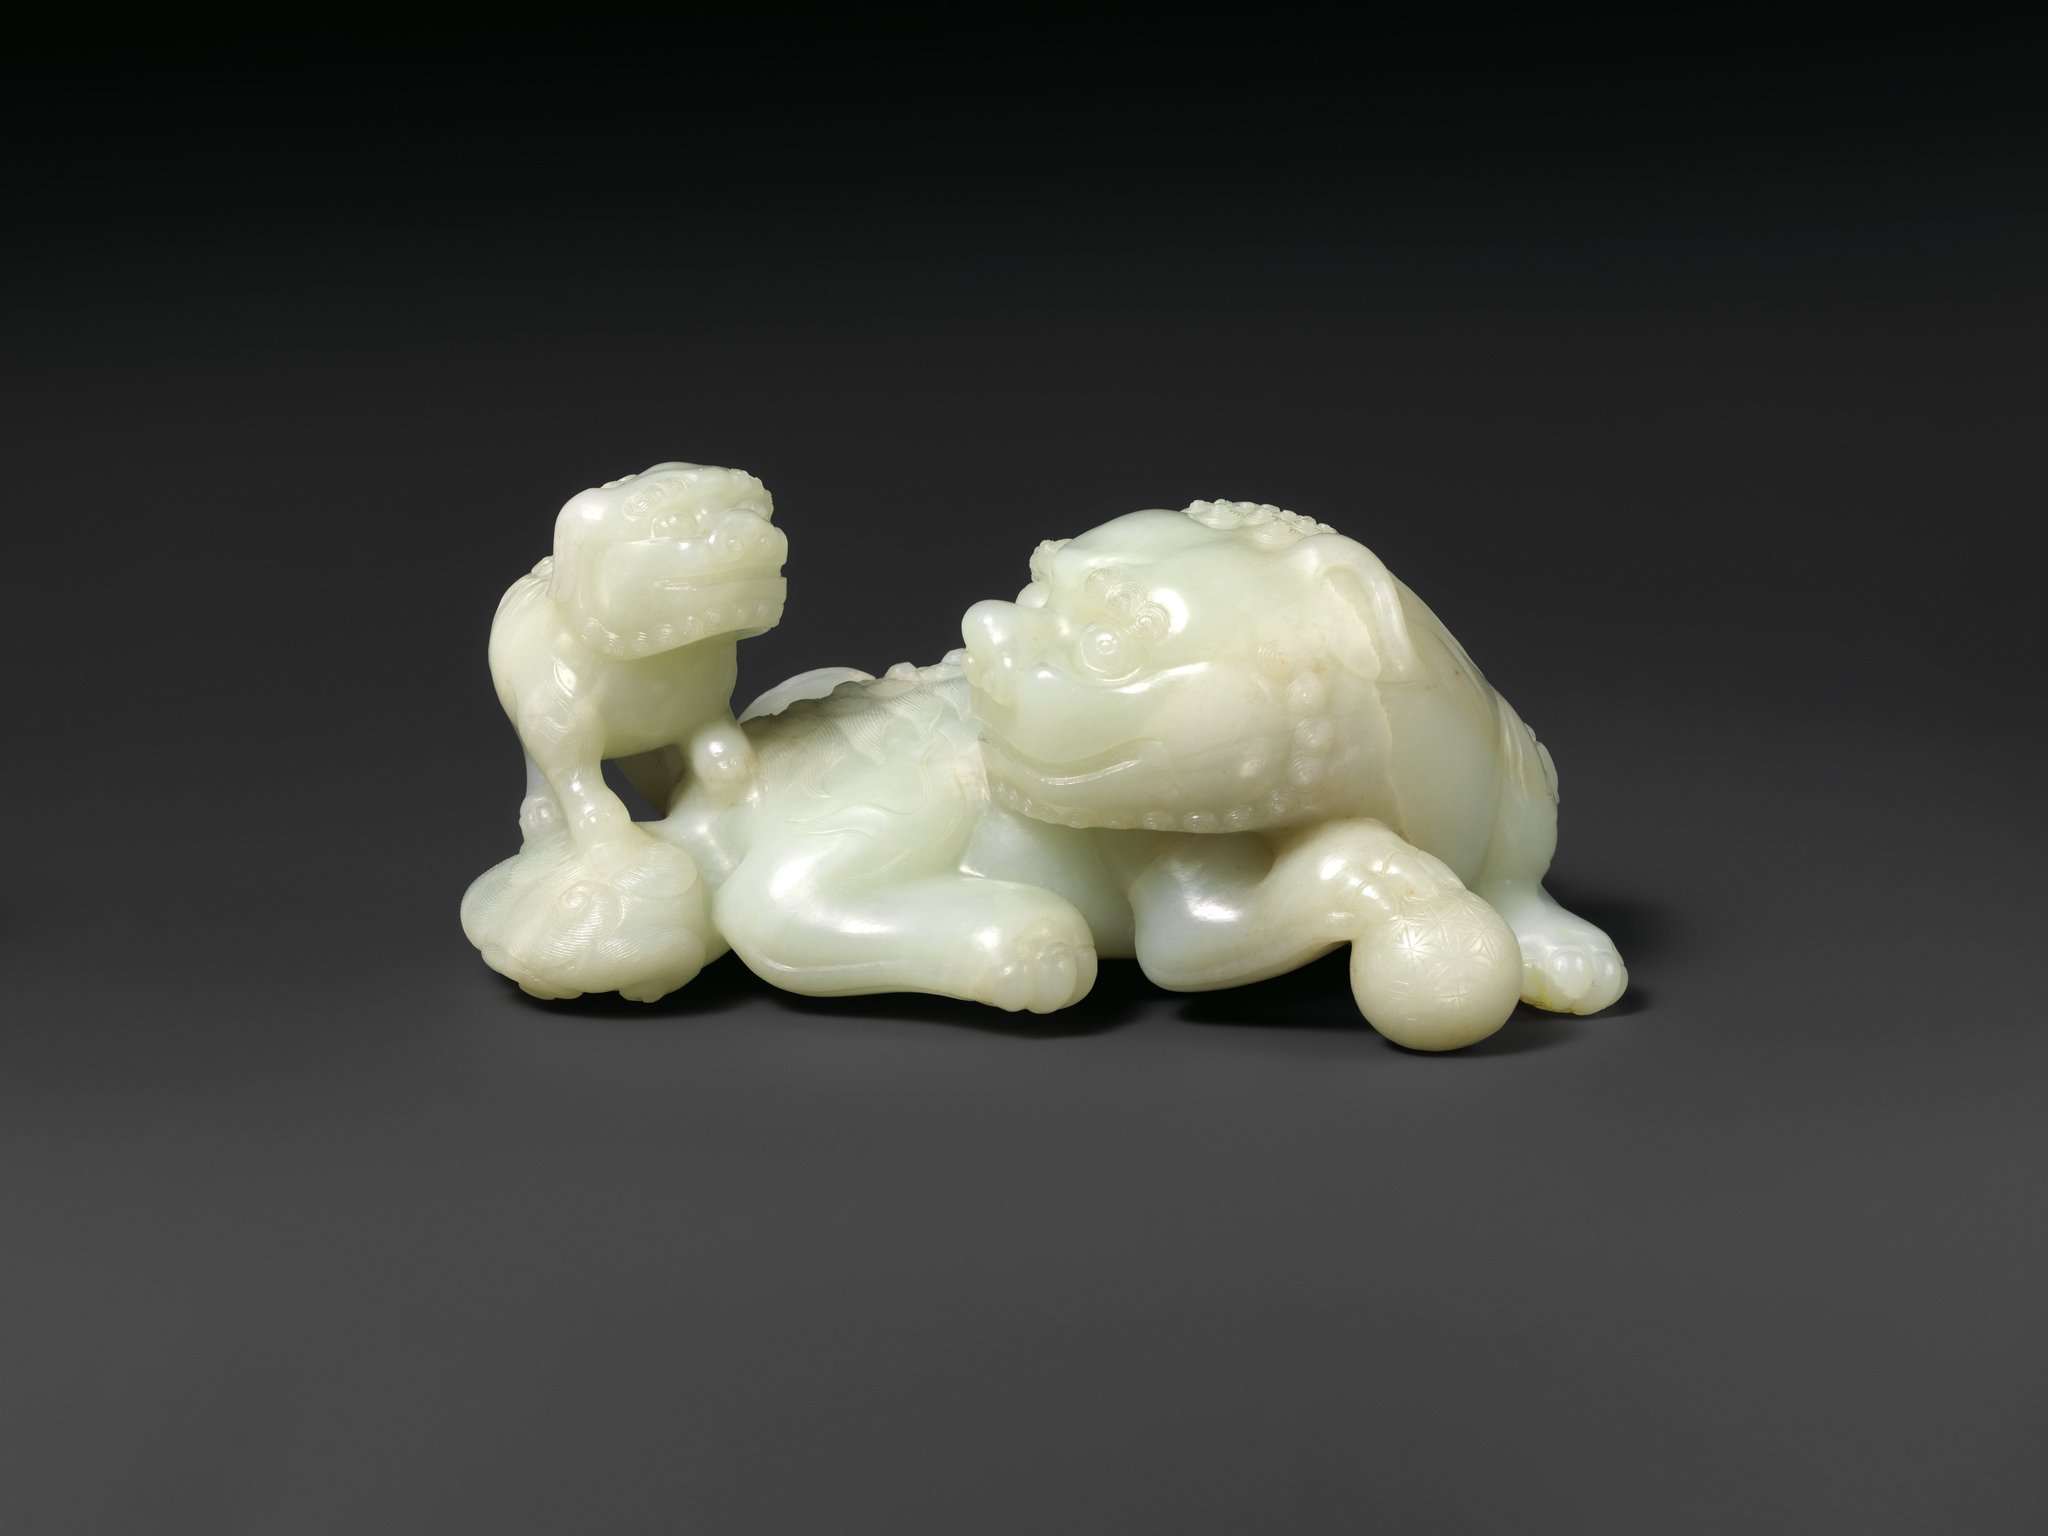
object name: figurine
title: Lion and cub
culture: chinese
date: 1701-1800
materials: jade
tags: lions